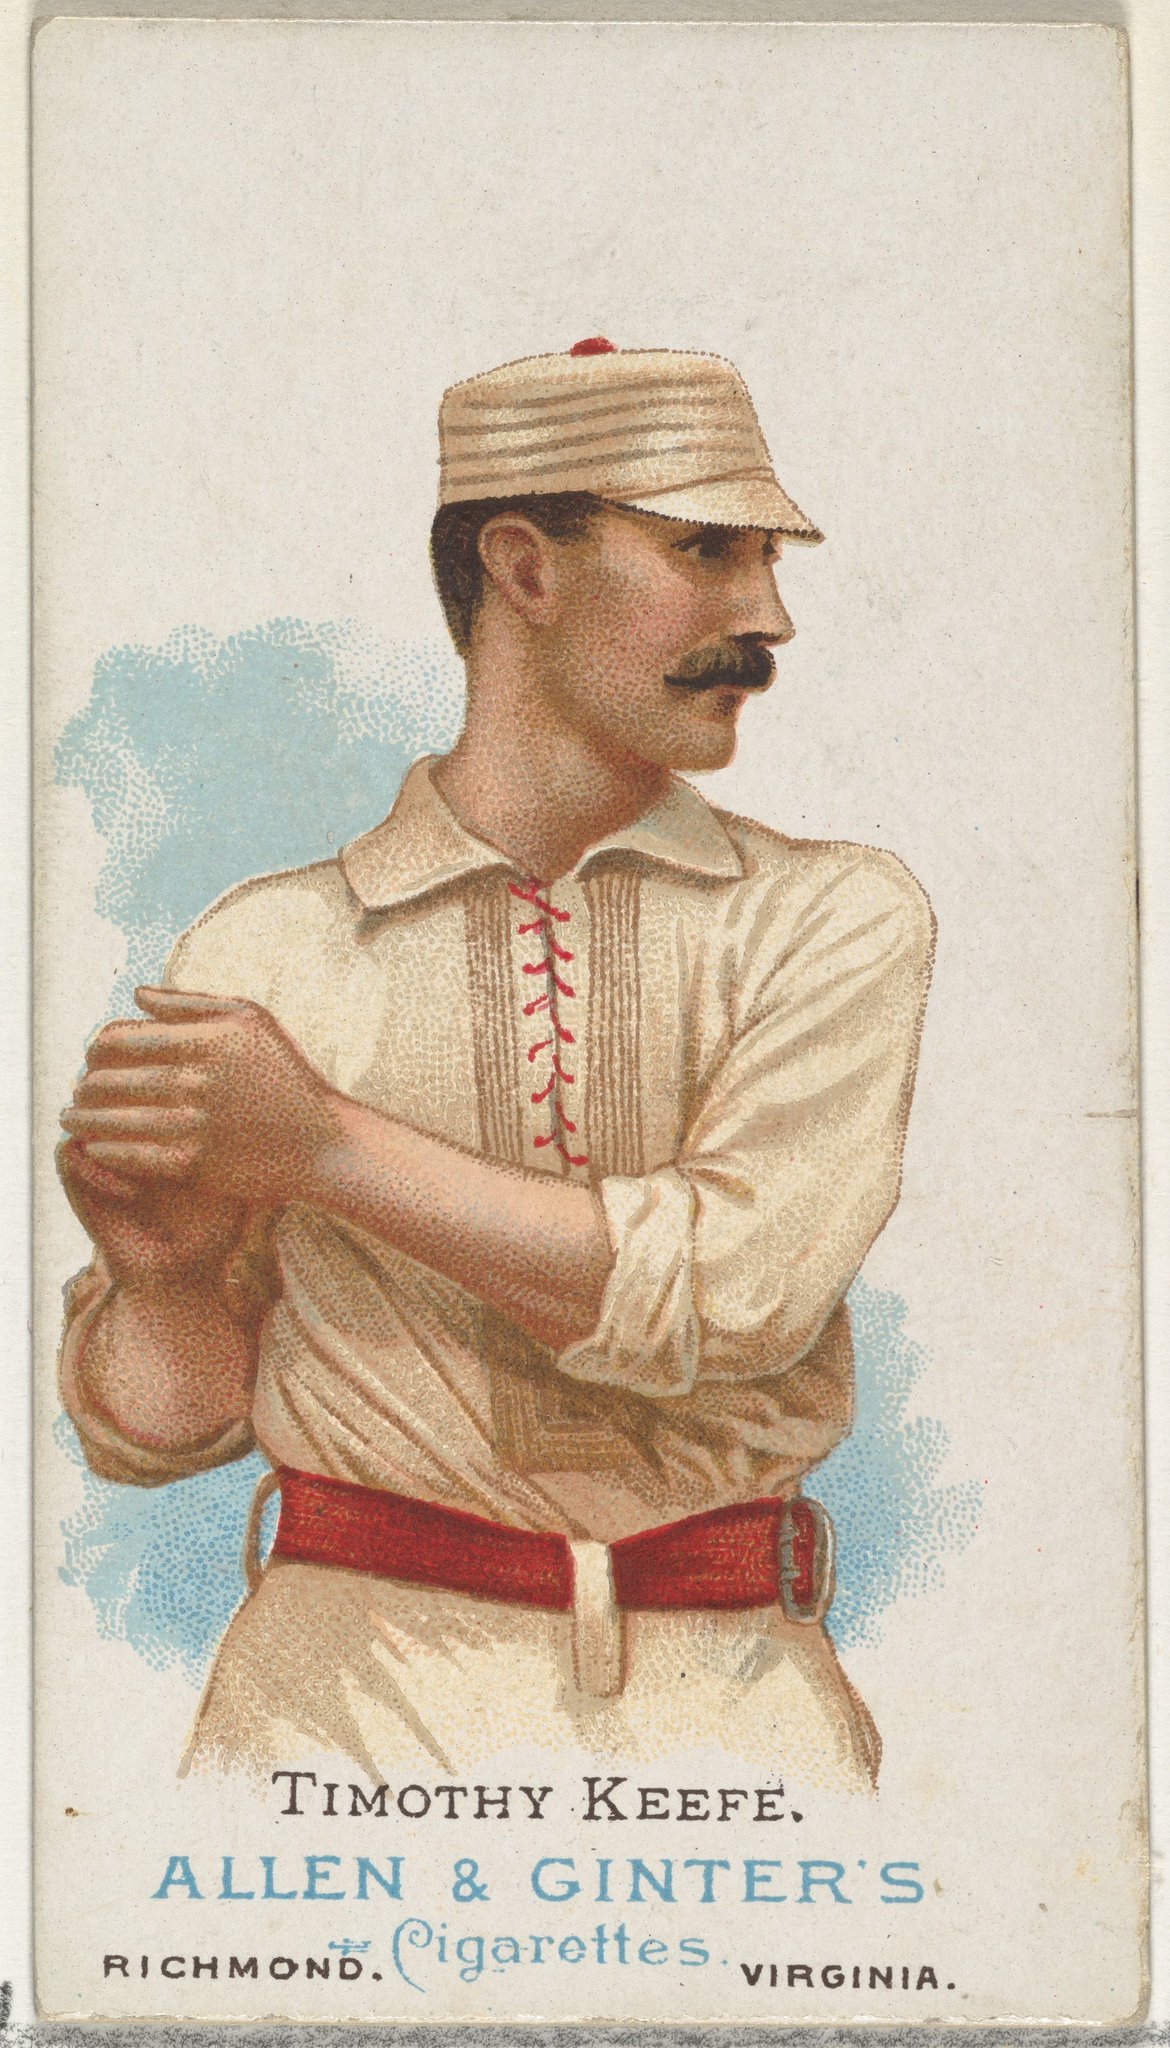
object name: baseball card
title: Timothy Keefe, Baseball Player, from World's Champions, Series 1 (N28) for Allen & Ginter Cigarettes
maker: allen & ginter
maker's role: publisher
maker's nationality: american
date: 1887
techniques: color lithograph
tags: men,baseball,athletes